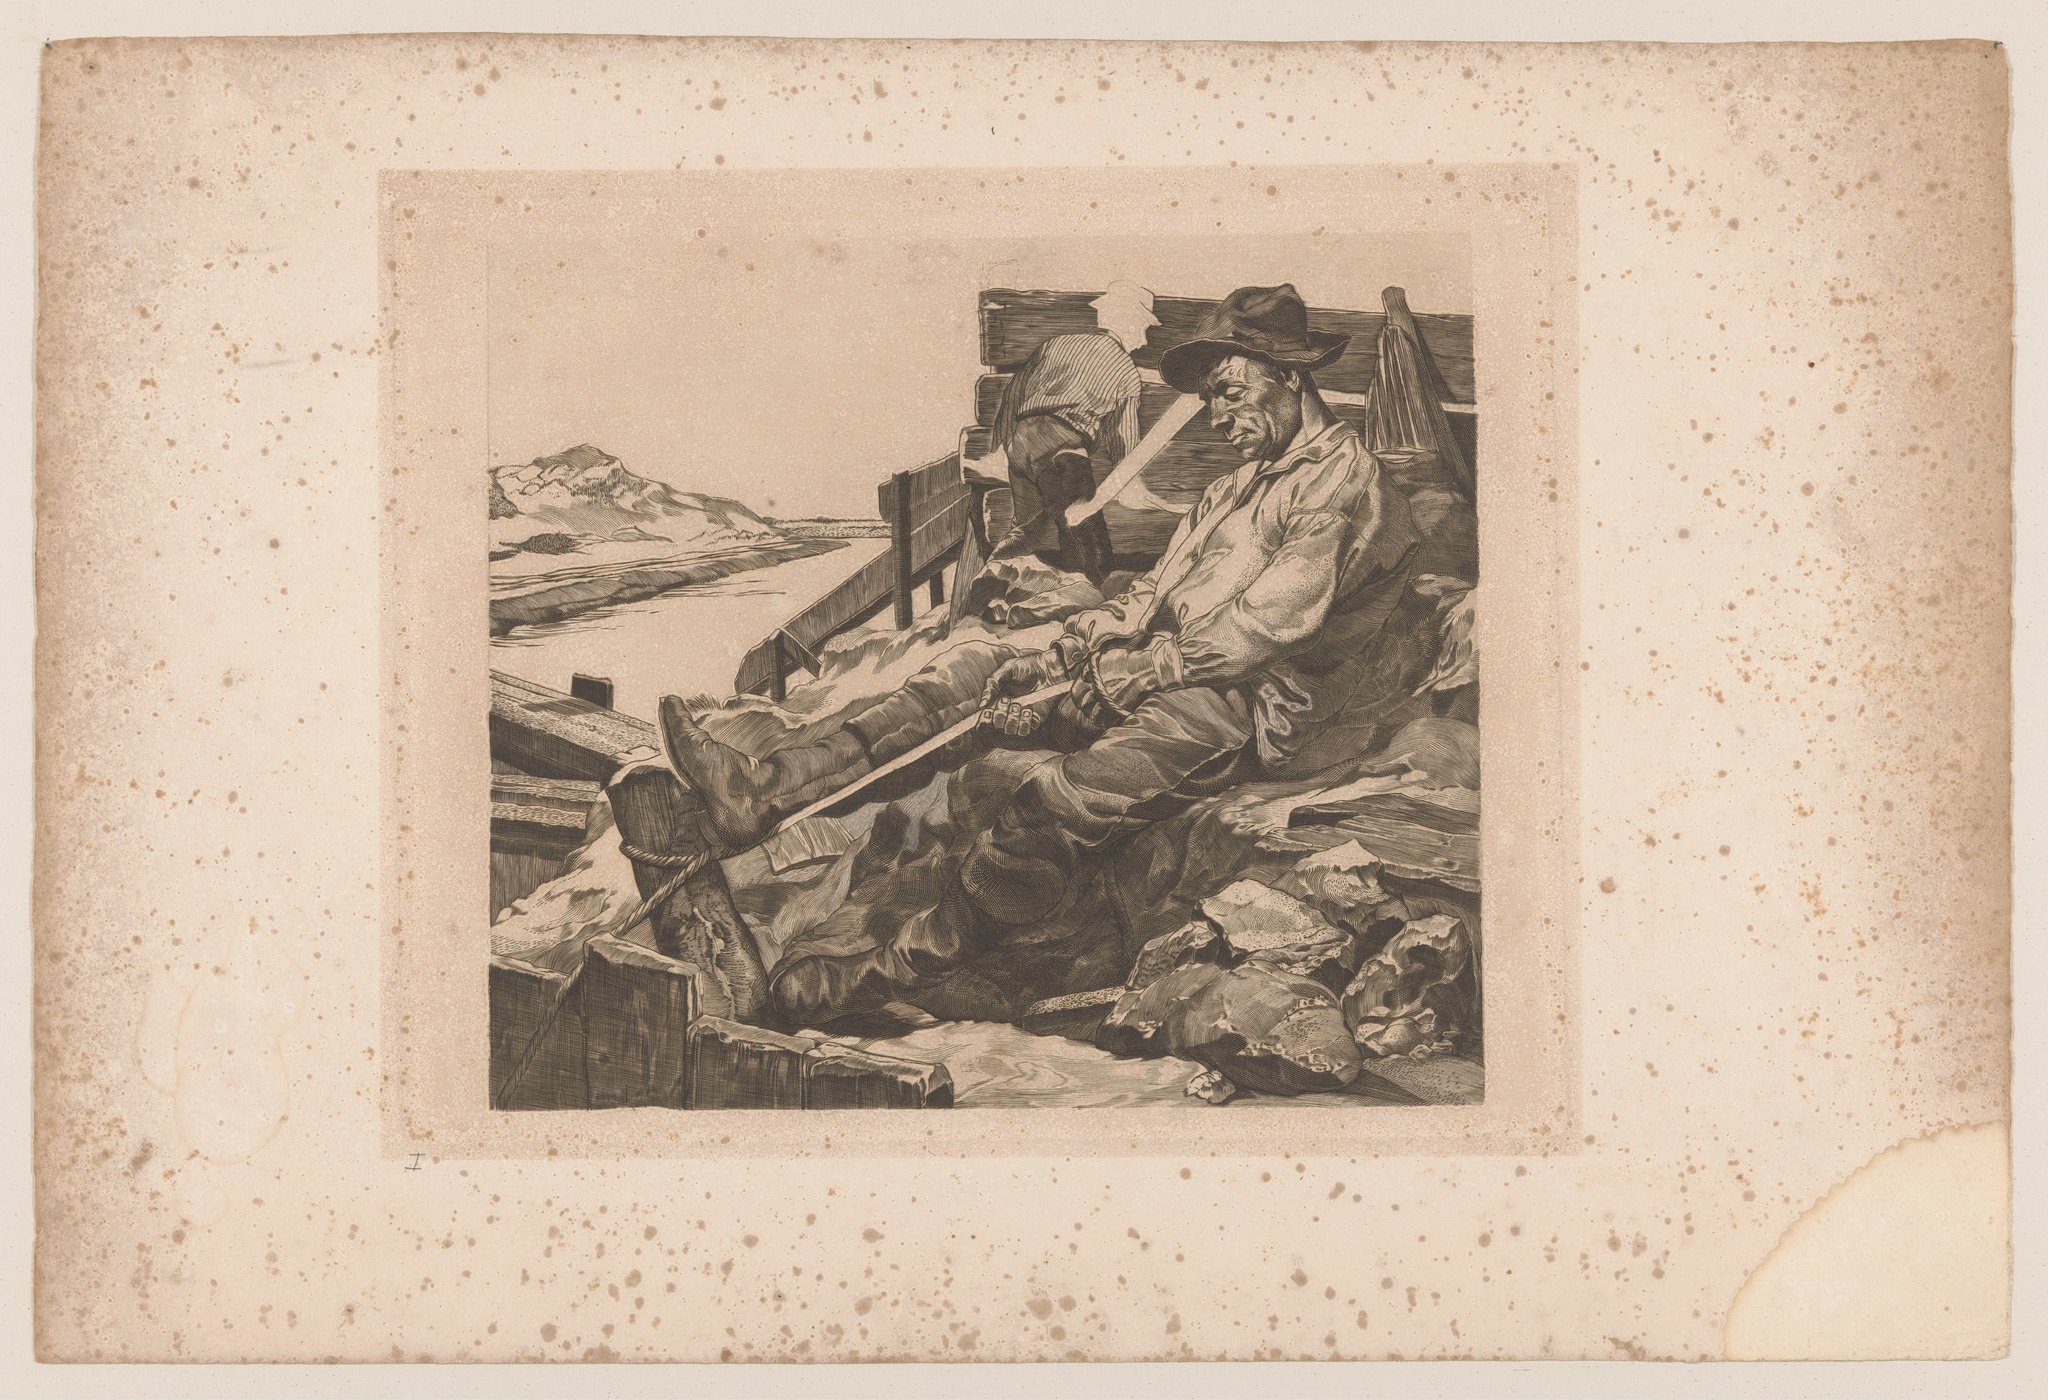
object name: print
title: Twee arbeiders bij een zandafgraving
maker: johannes josephus aarts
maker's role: draughtsman, print maker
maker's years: 1871-1934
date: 1902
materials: chalk, paper, pencil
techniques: engraving, intaglio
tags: working class, labourers, tools, aids, implements ~ crafts and industries: rope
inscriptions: collector's mark: Lugt 2166, collector's mark: Lugt 2228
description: Twee mannen in werkkleding en met hoed. Op de voorgrond spant een man een touw om een paal door zich met zijn voet tegen de paal af te zetten. Op de achtergrond een zandduin, een vaart en een houten hek, waarbij de andere man zich ophoudt.